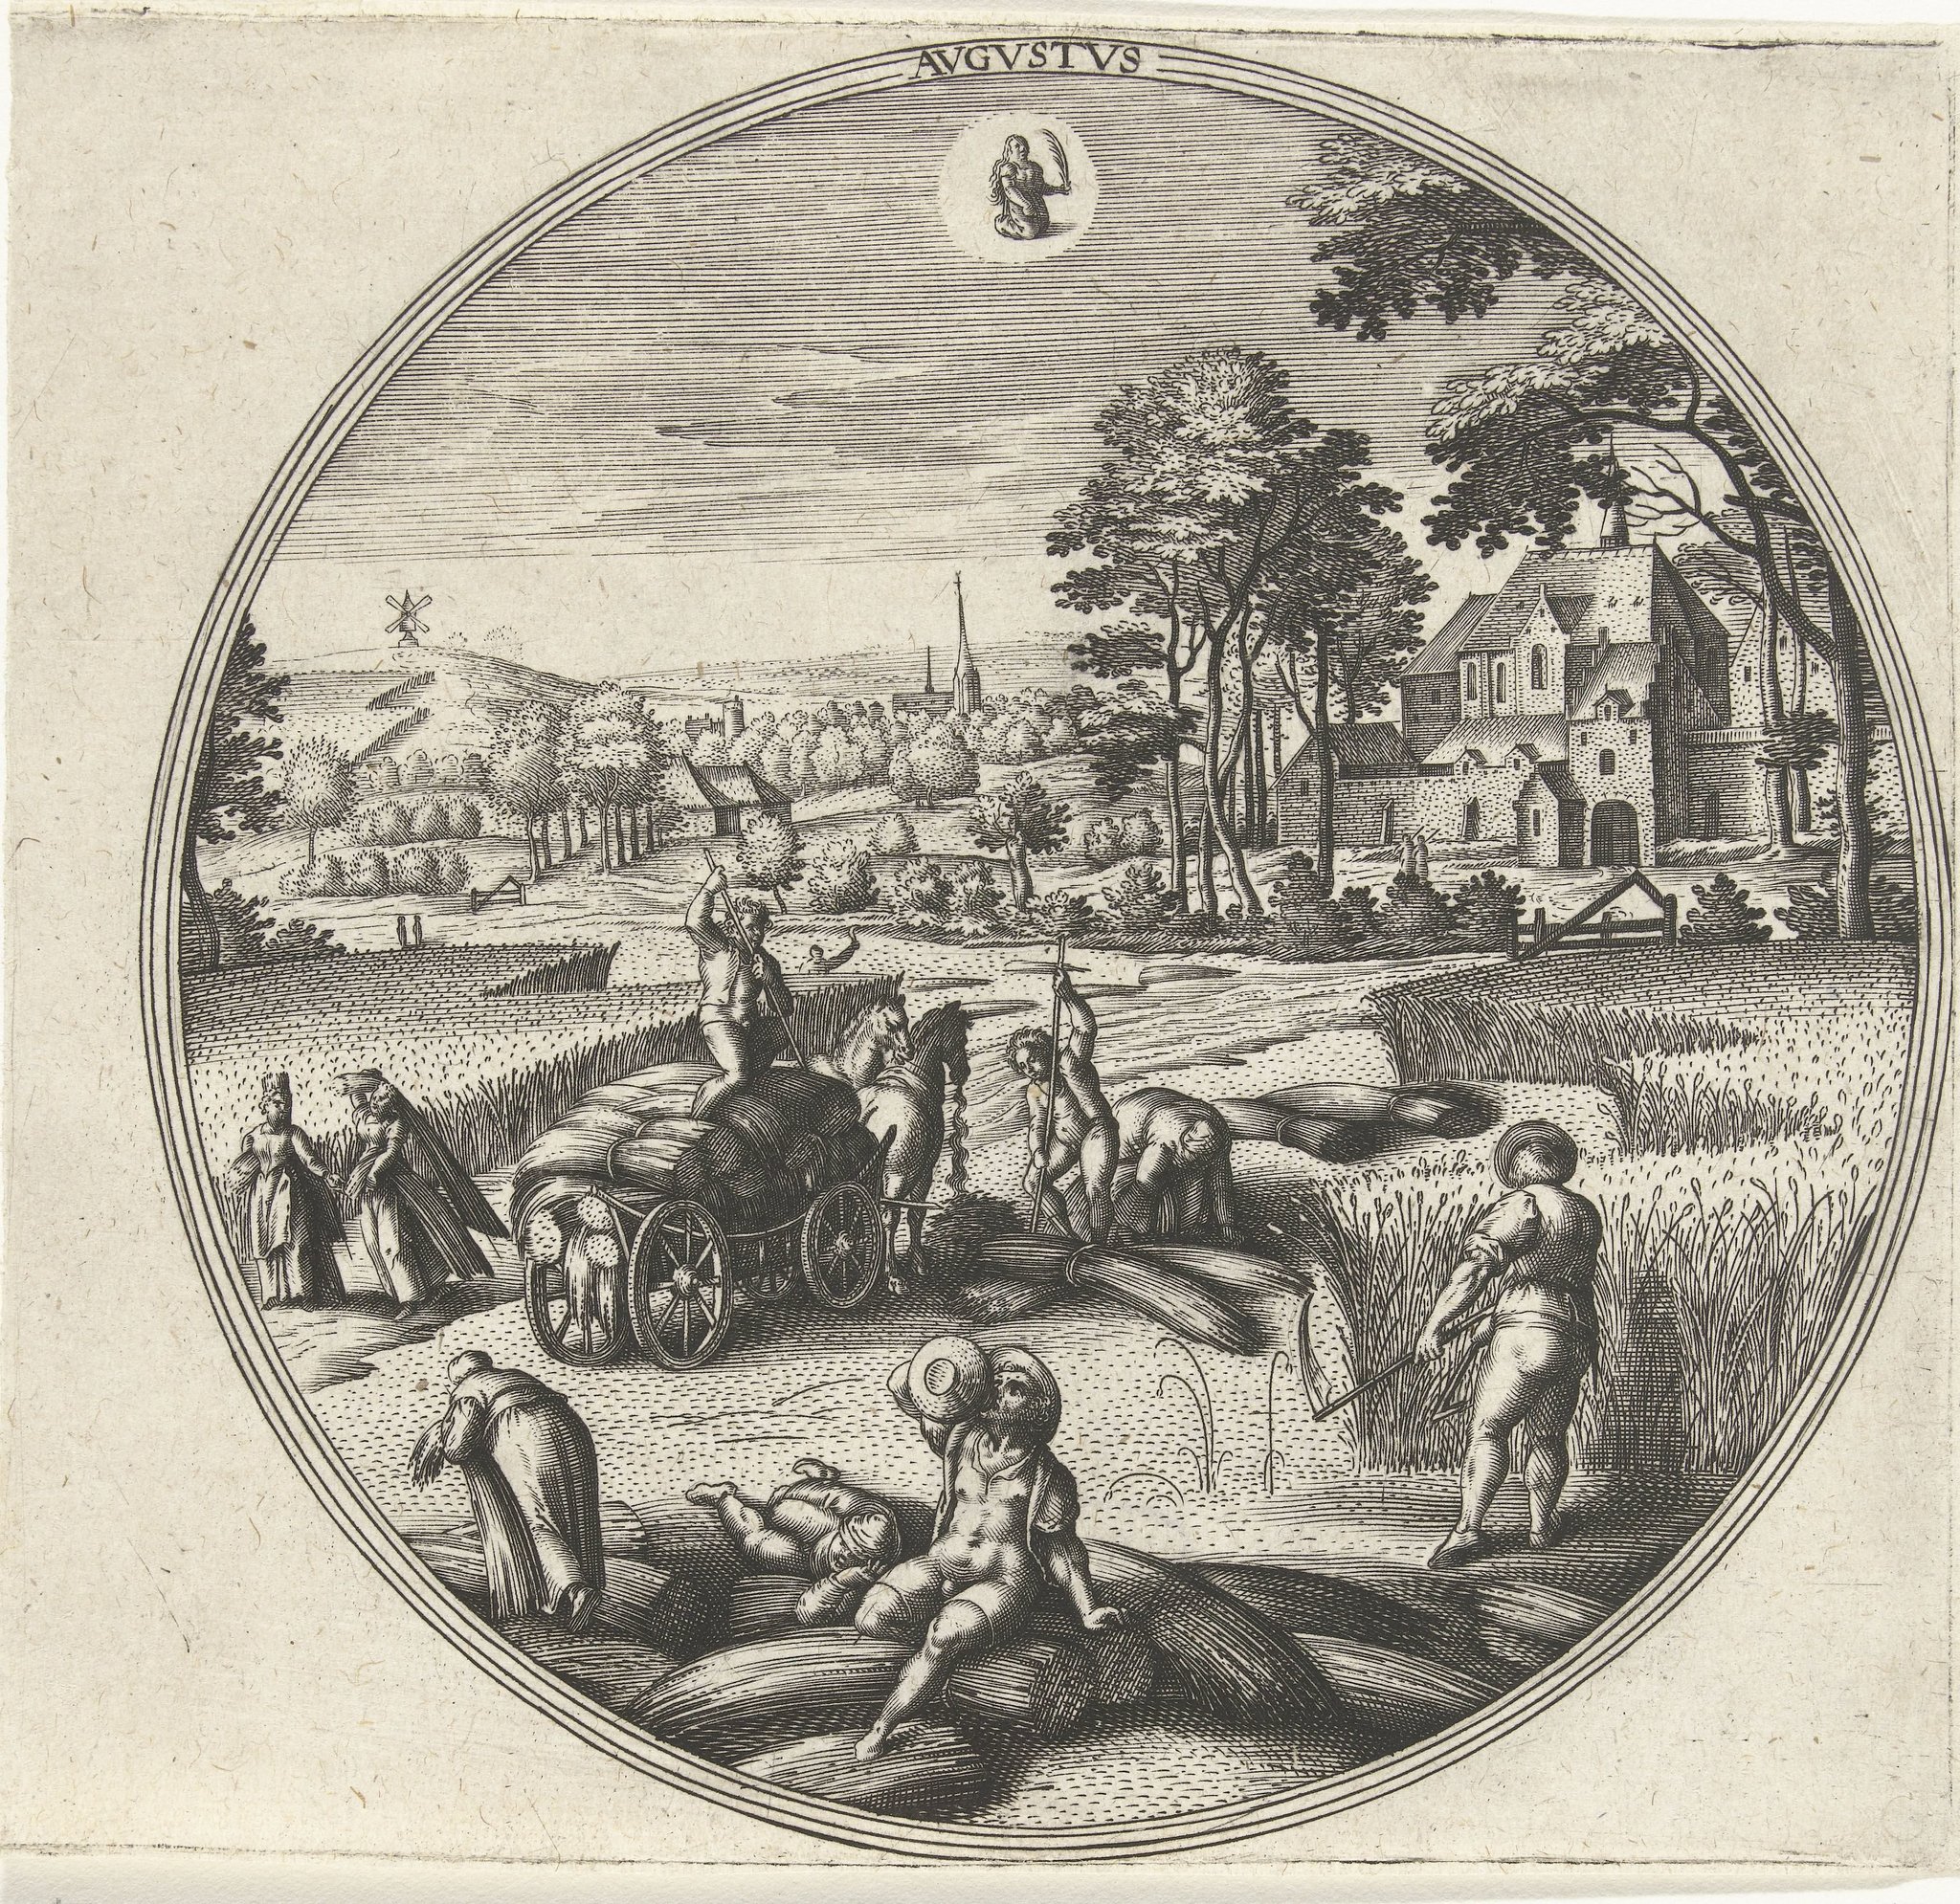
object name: print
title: Augustus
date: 1578-1582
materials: paper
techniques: engraving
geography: antwerp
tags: rest during harvest (eating, dancing, making love, etc.), dipping, washing (sheep or other animals), reaping, picking, mowing ~ harvest, august and its 'labours' (+ with zodiacal signs)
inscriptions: collector's mark: Lugt 2228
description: Ronde lijst met zomerlandschap met zomertaferelen. Augustus is de oogstmaand. Centraal staat dus het oogsten van graan. Oogstwagens brengen het graan naar de schuur. Enkele landbouwers zijn juist toe aan hun rustpauze. Middenboven het sterrenbeeld Maagd. De prent is deel van een twaalfdelige serie over de twaalf maanden.